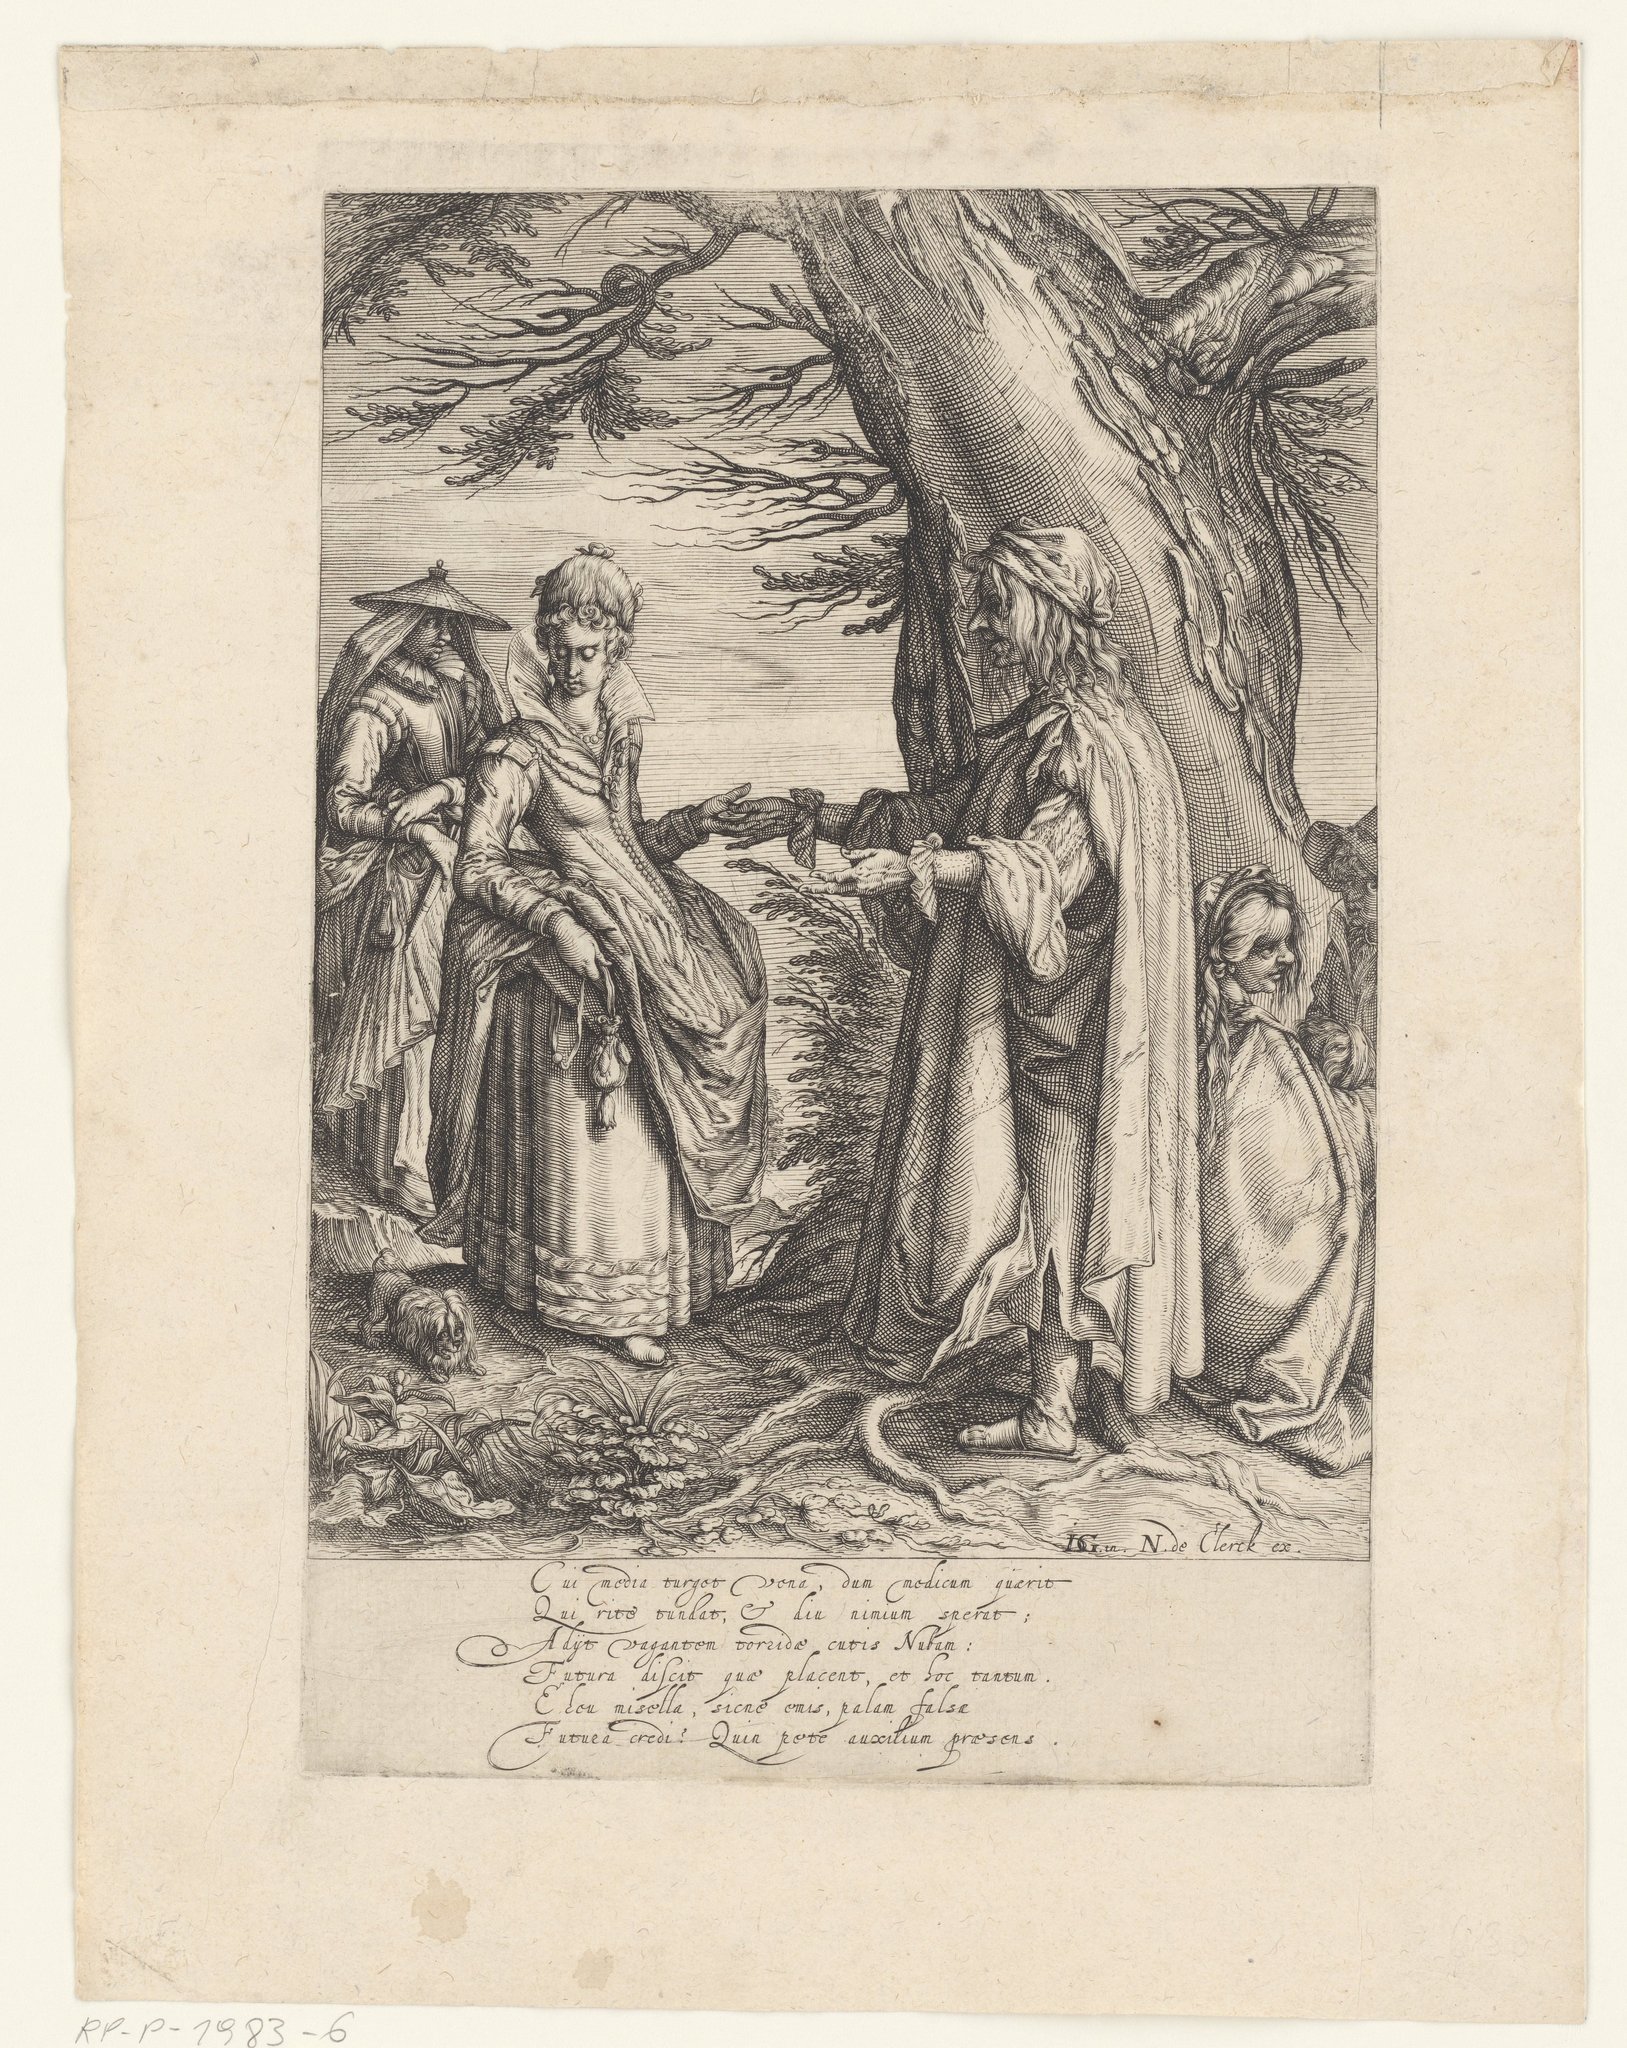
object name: print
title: De waarzegster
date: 1606-1610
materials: paper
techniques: engraving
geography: delft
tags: chiromancy, handreading, palmistry, wandering communities: romani or roma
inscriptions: caption: ‘Cui media turget vena, dum medicum quaerit...Futura credi ? Quin pete auxilium praesens’ het voorspellen van de toekomst is met bedrog omgeven; houd je met het heden bezig., collector's mark: Lugt 2228a, collector's mark: Lugt 2760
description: Een Roma vrouw (Nuba volgens het onderschrift) staat voor een dikke boom tegenover een jonge elegante dame - zij leest haar de hand en/of neemt een geldstuk van haar aan. Achter de jonge vrouw een dame met een hoed op, naast haar een klein hondje. Rechts twee zittende Roma vrouwen, één met een baby in de armen. In het zesregelige Latijnse onderschrift wordt de jongedame als een goedgelovige stakker afgeschilderd, die alleen de toekomst te horen krijgt die ze graag hoort